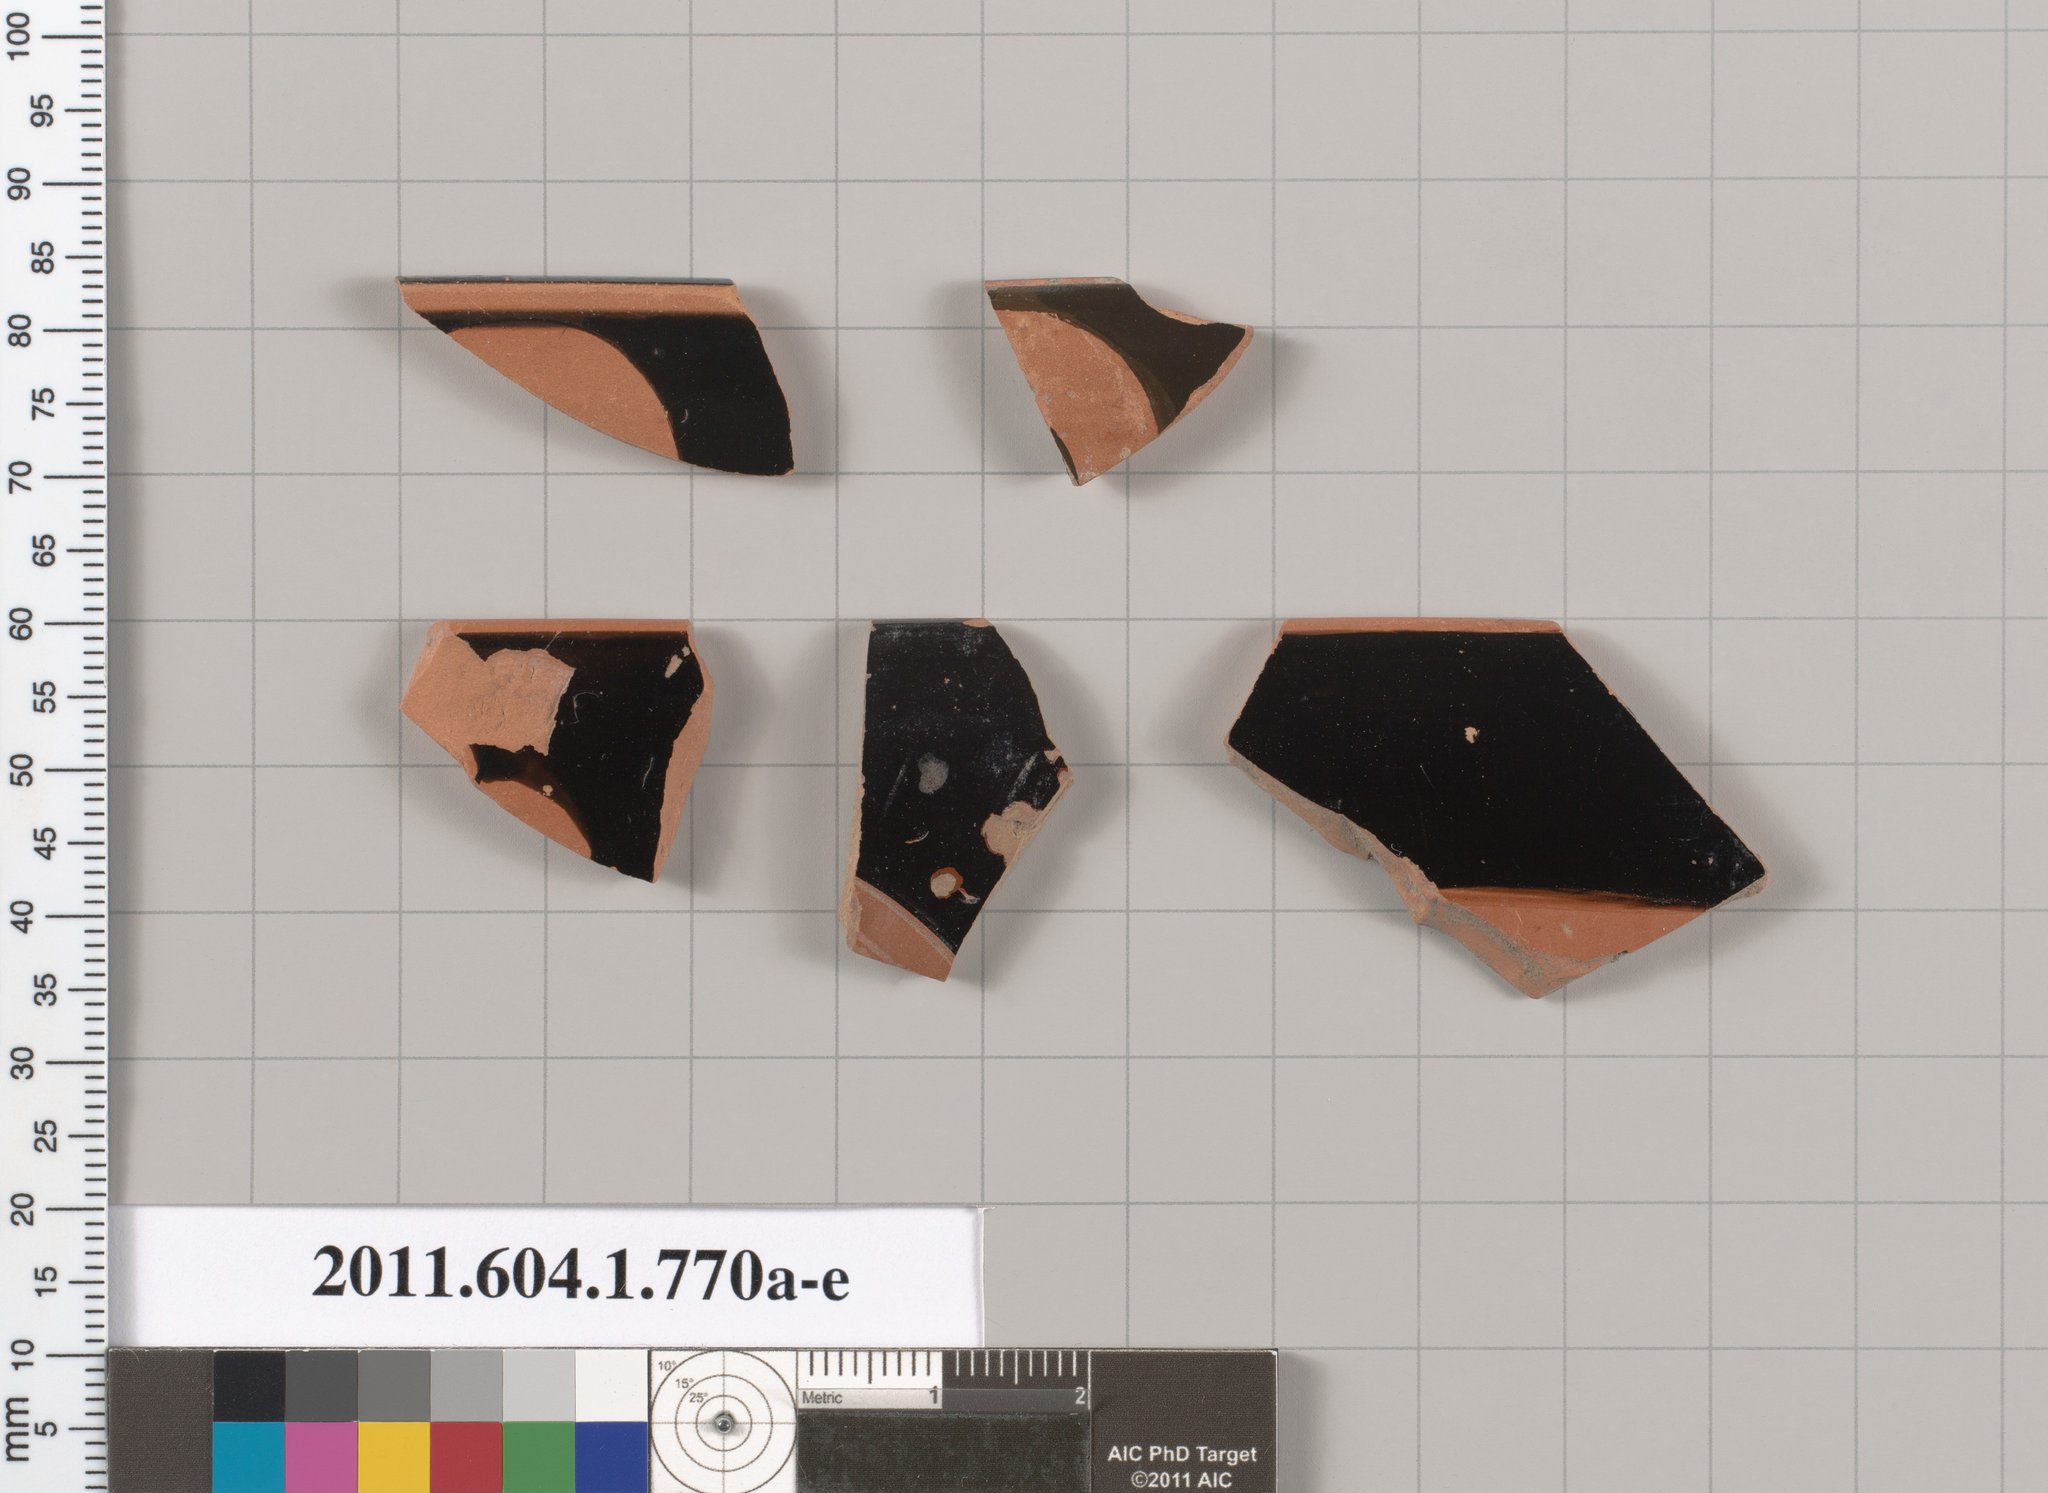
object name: kylix fragment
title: Terracotta rim fragments of kylikes (drinking cups)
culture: greek, attic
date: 500-401 BCE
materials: terracotta